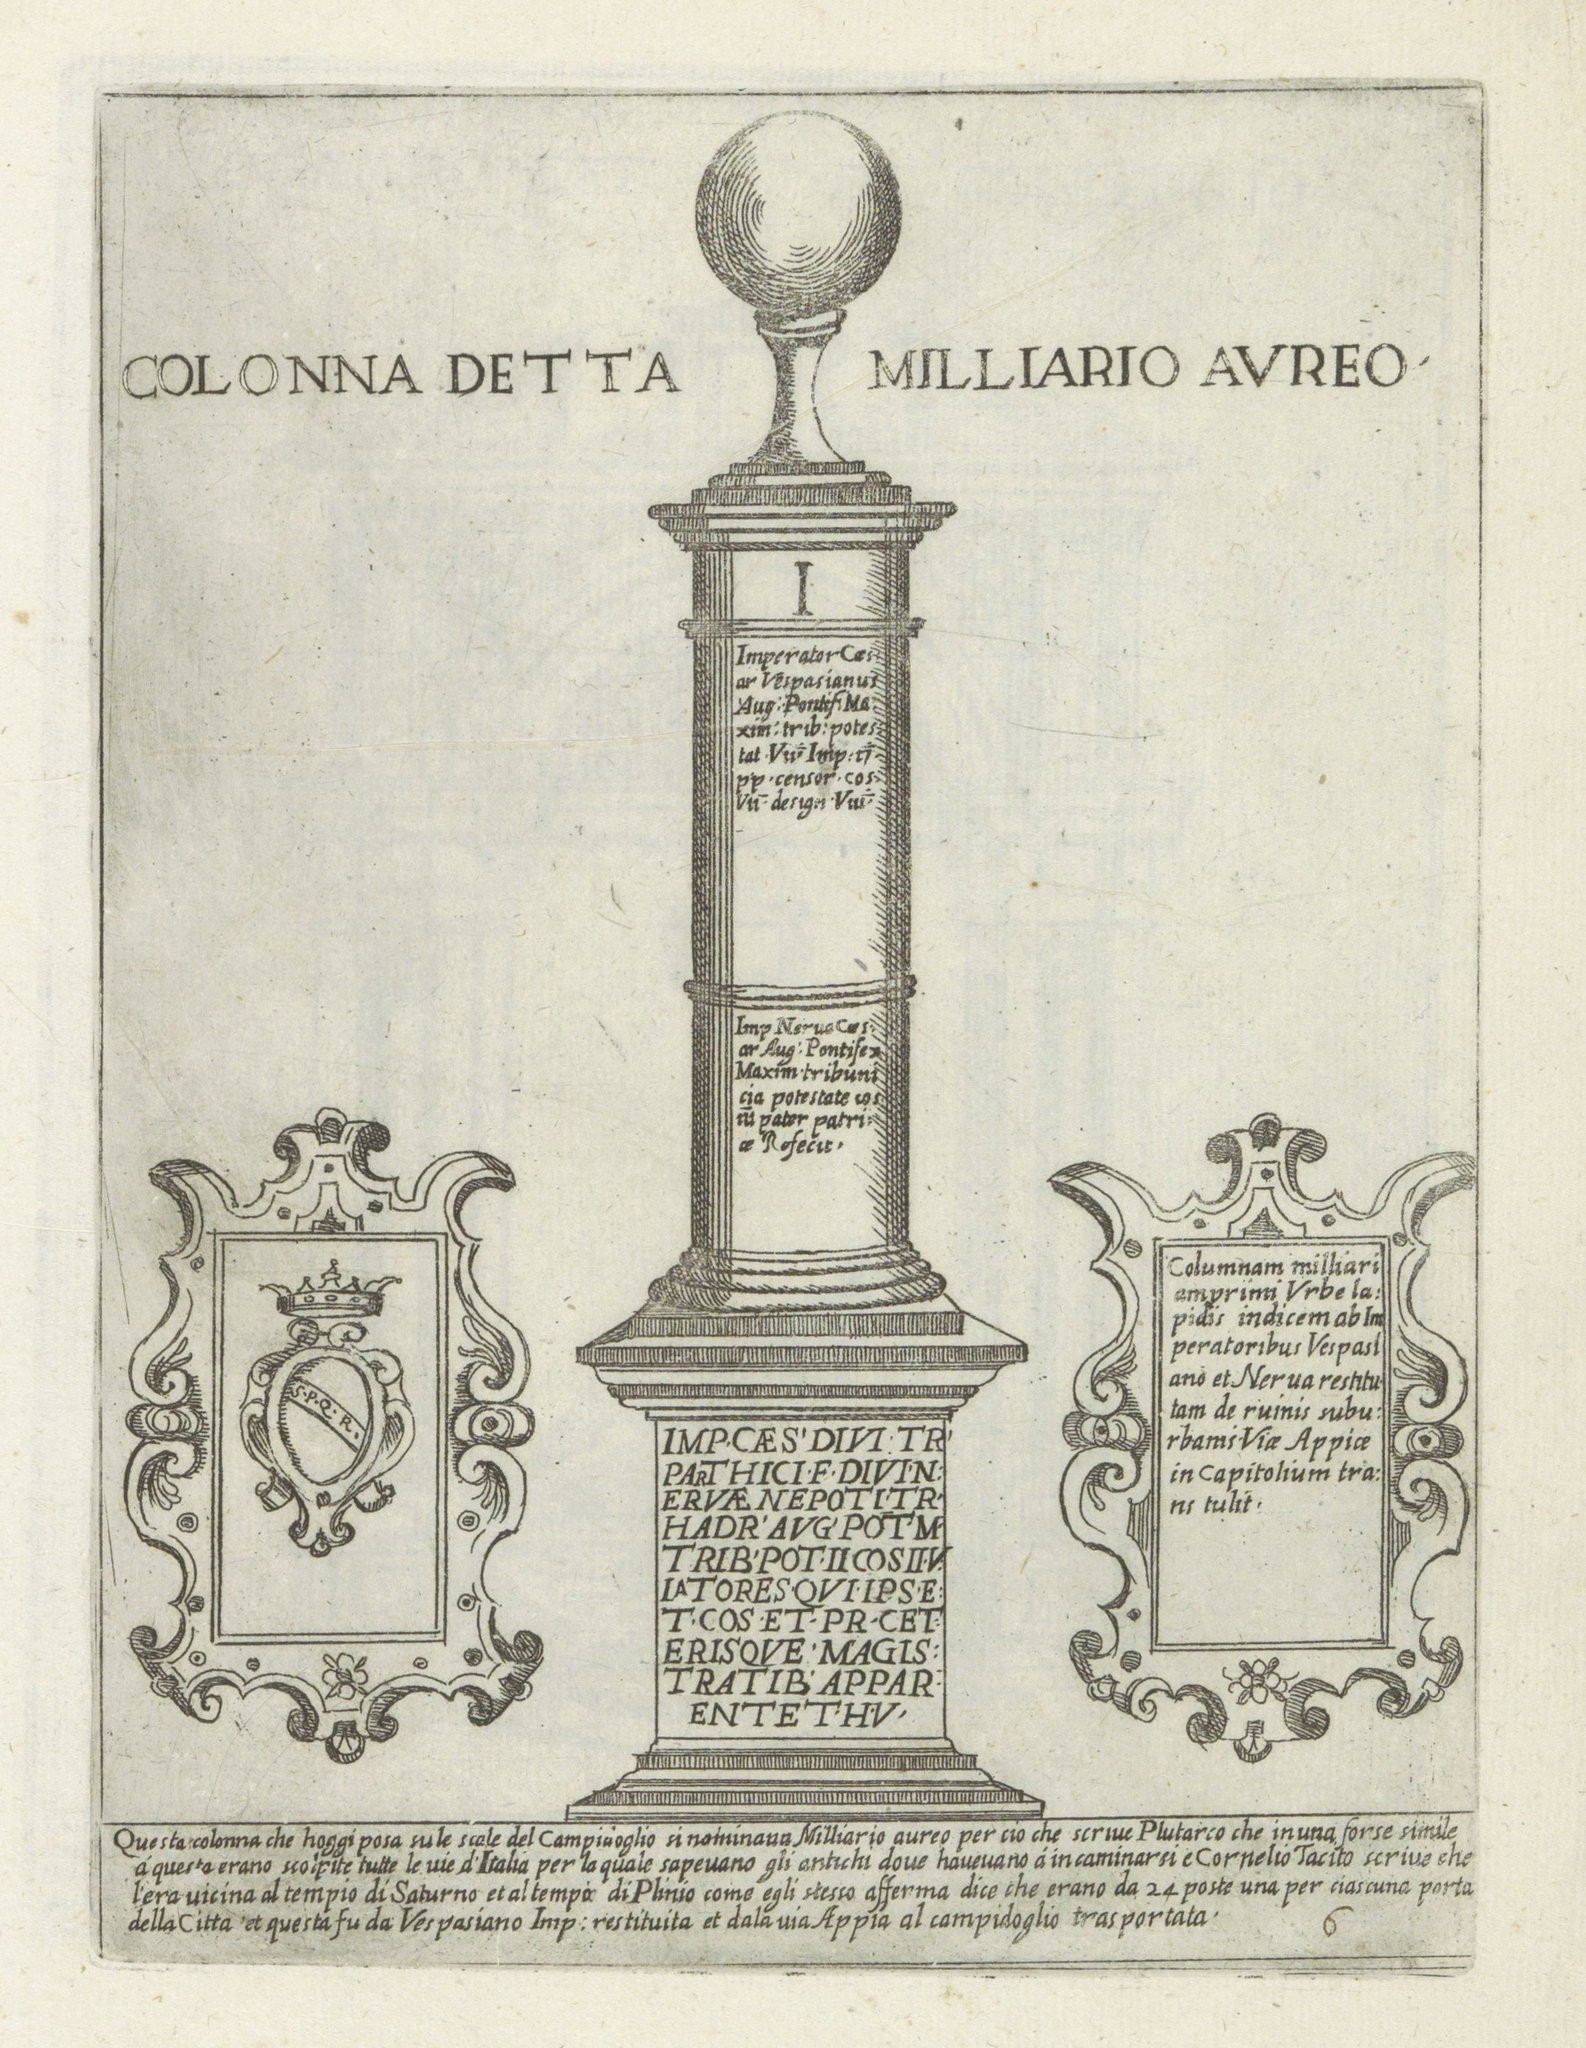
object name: print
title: De Milliarium Aureum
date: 1576-1618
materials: paper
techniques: etching, intaglio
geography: italy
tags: piece of sculpture, reproduction of a piece of sculpture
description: De Milliarium Aureum (de Gouden Mijlpaal) was een Romeinse mijlpaal op het Forum Romanum in Rome, die het punt aangaf waar alle Romeinse wegen zouden beginnen. Tekst in het Italiaans en Latijn in ondermarge, in een cartouche en op de zuil. De prent maakt deel uit van een album.